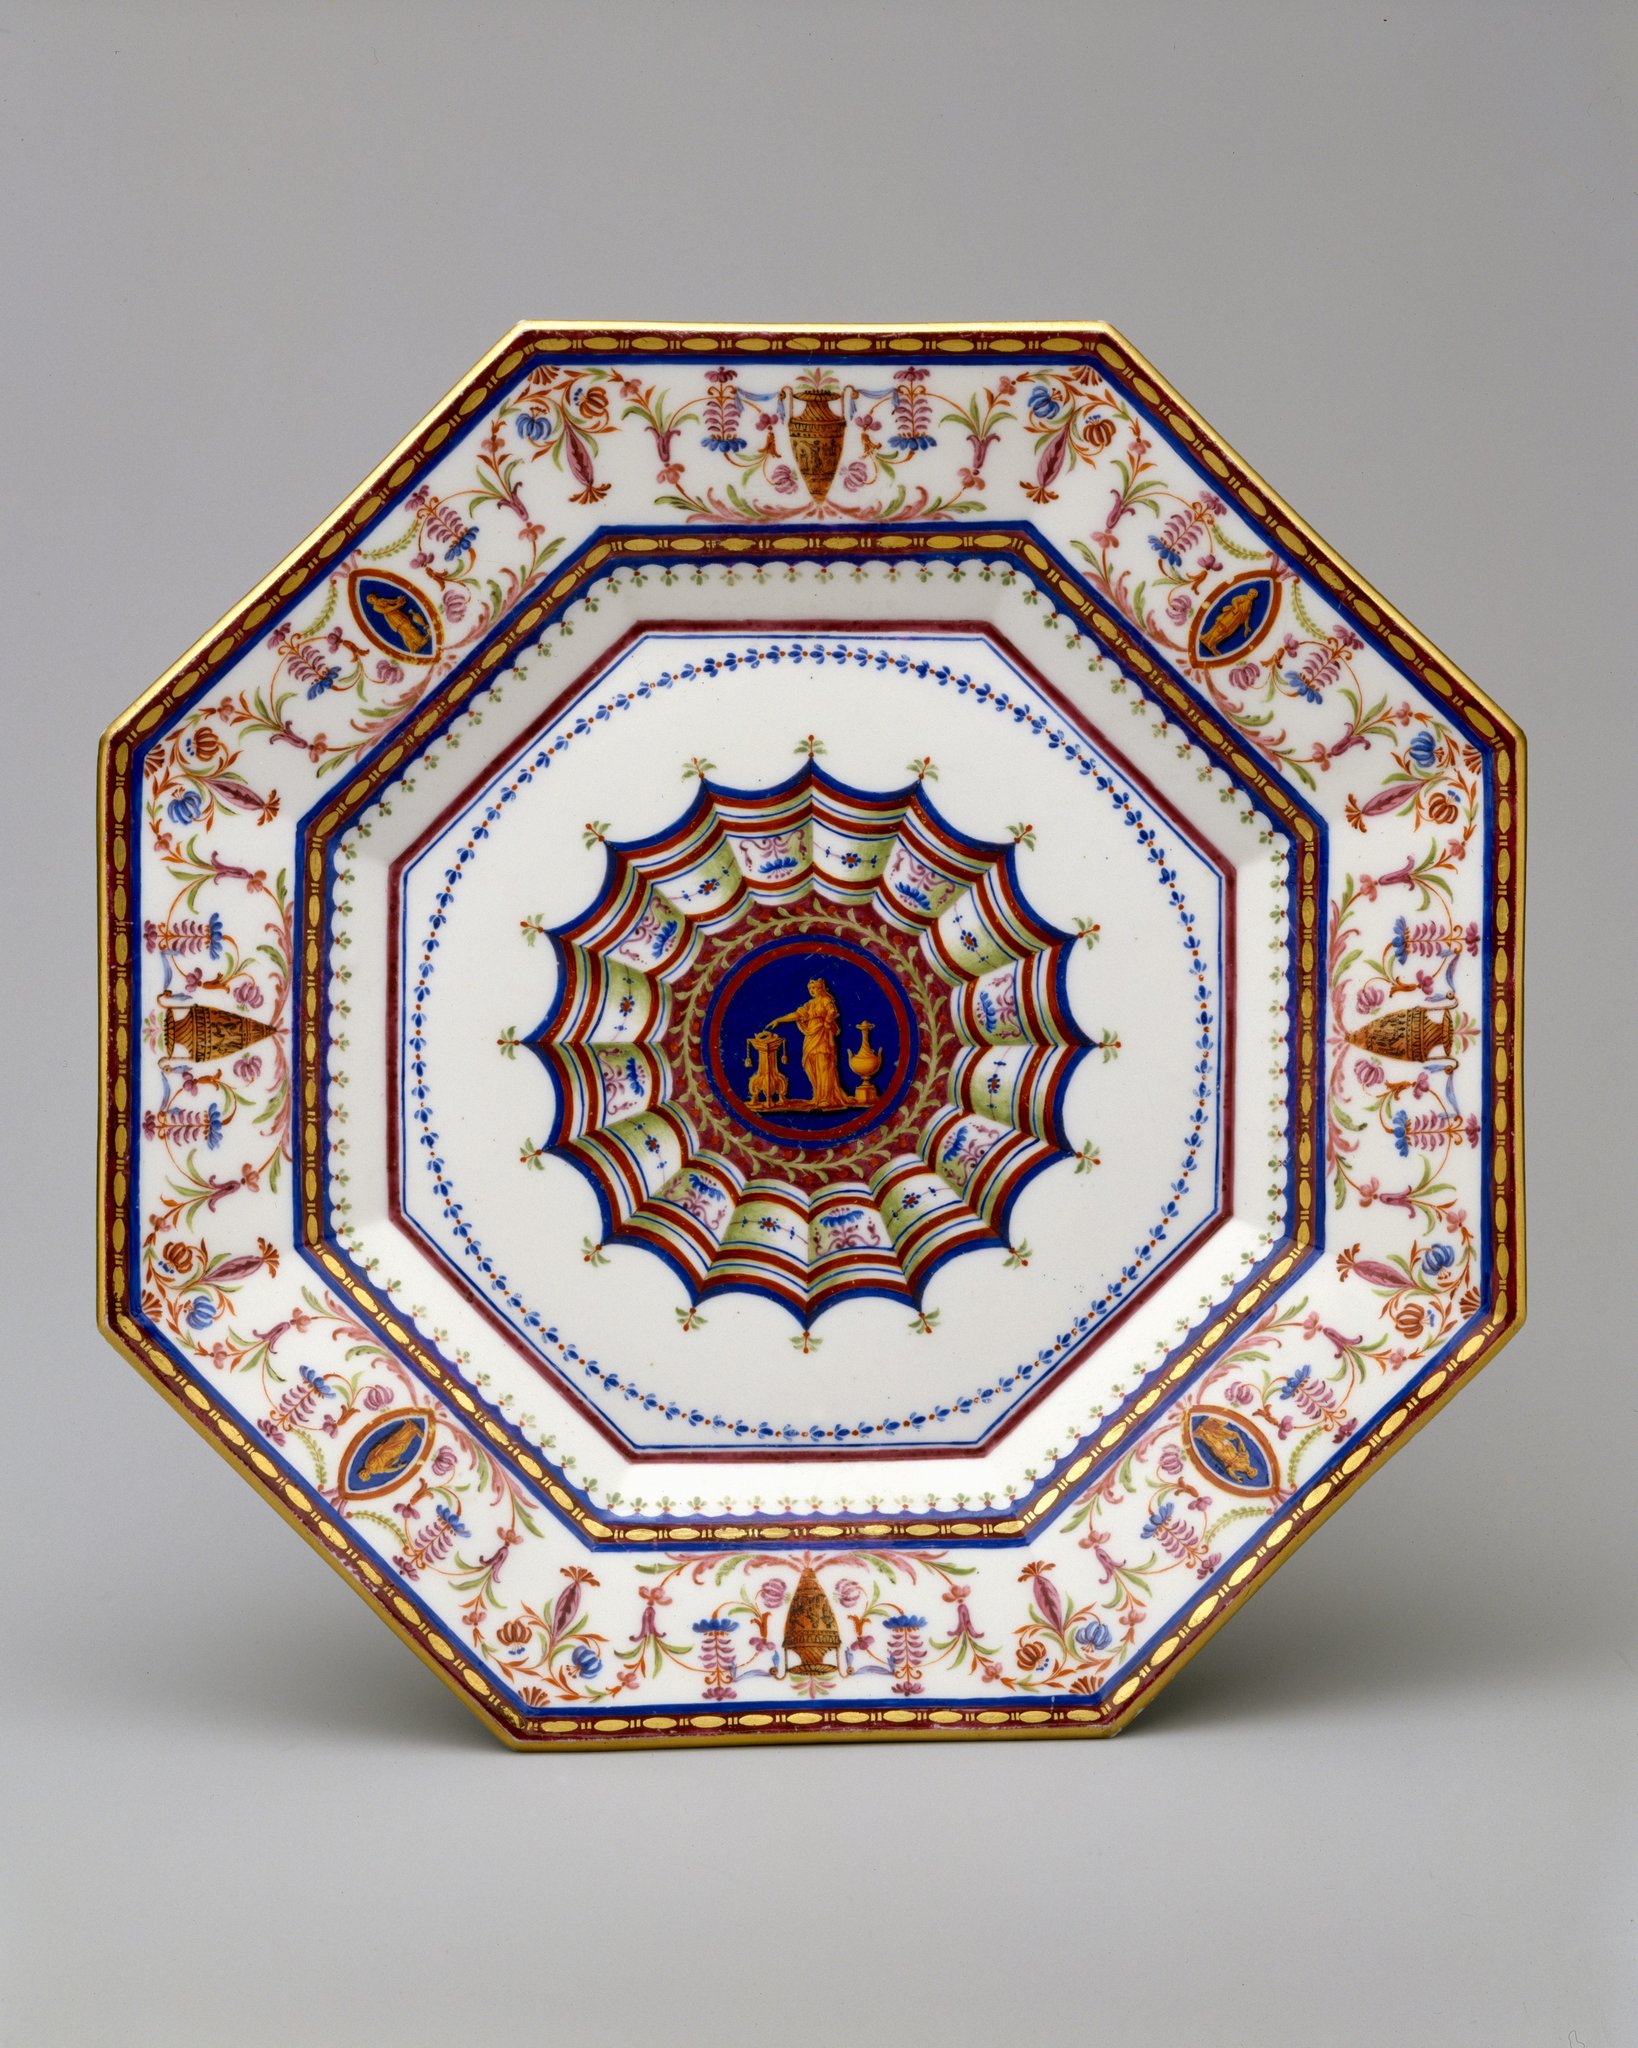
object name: plate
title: Plate (assiette octogone or assiette platte) from the "Service Arabesque"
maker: sèvres manufactory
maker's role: manufactory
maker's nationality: french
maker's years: 1740-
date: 1783-1785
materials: soft paste porcelain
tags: women